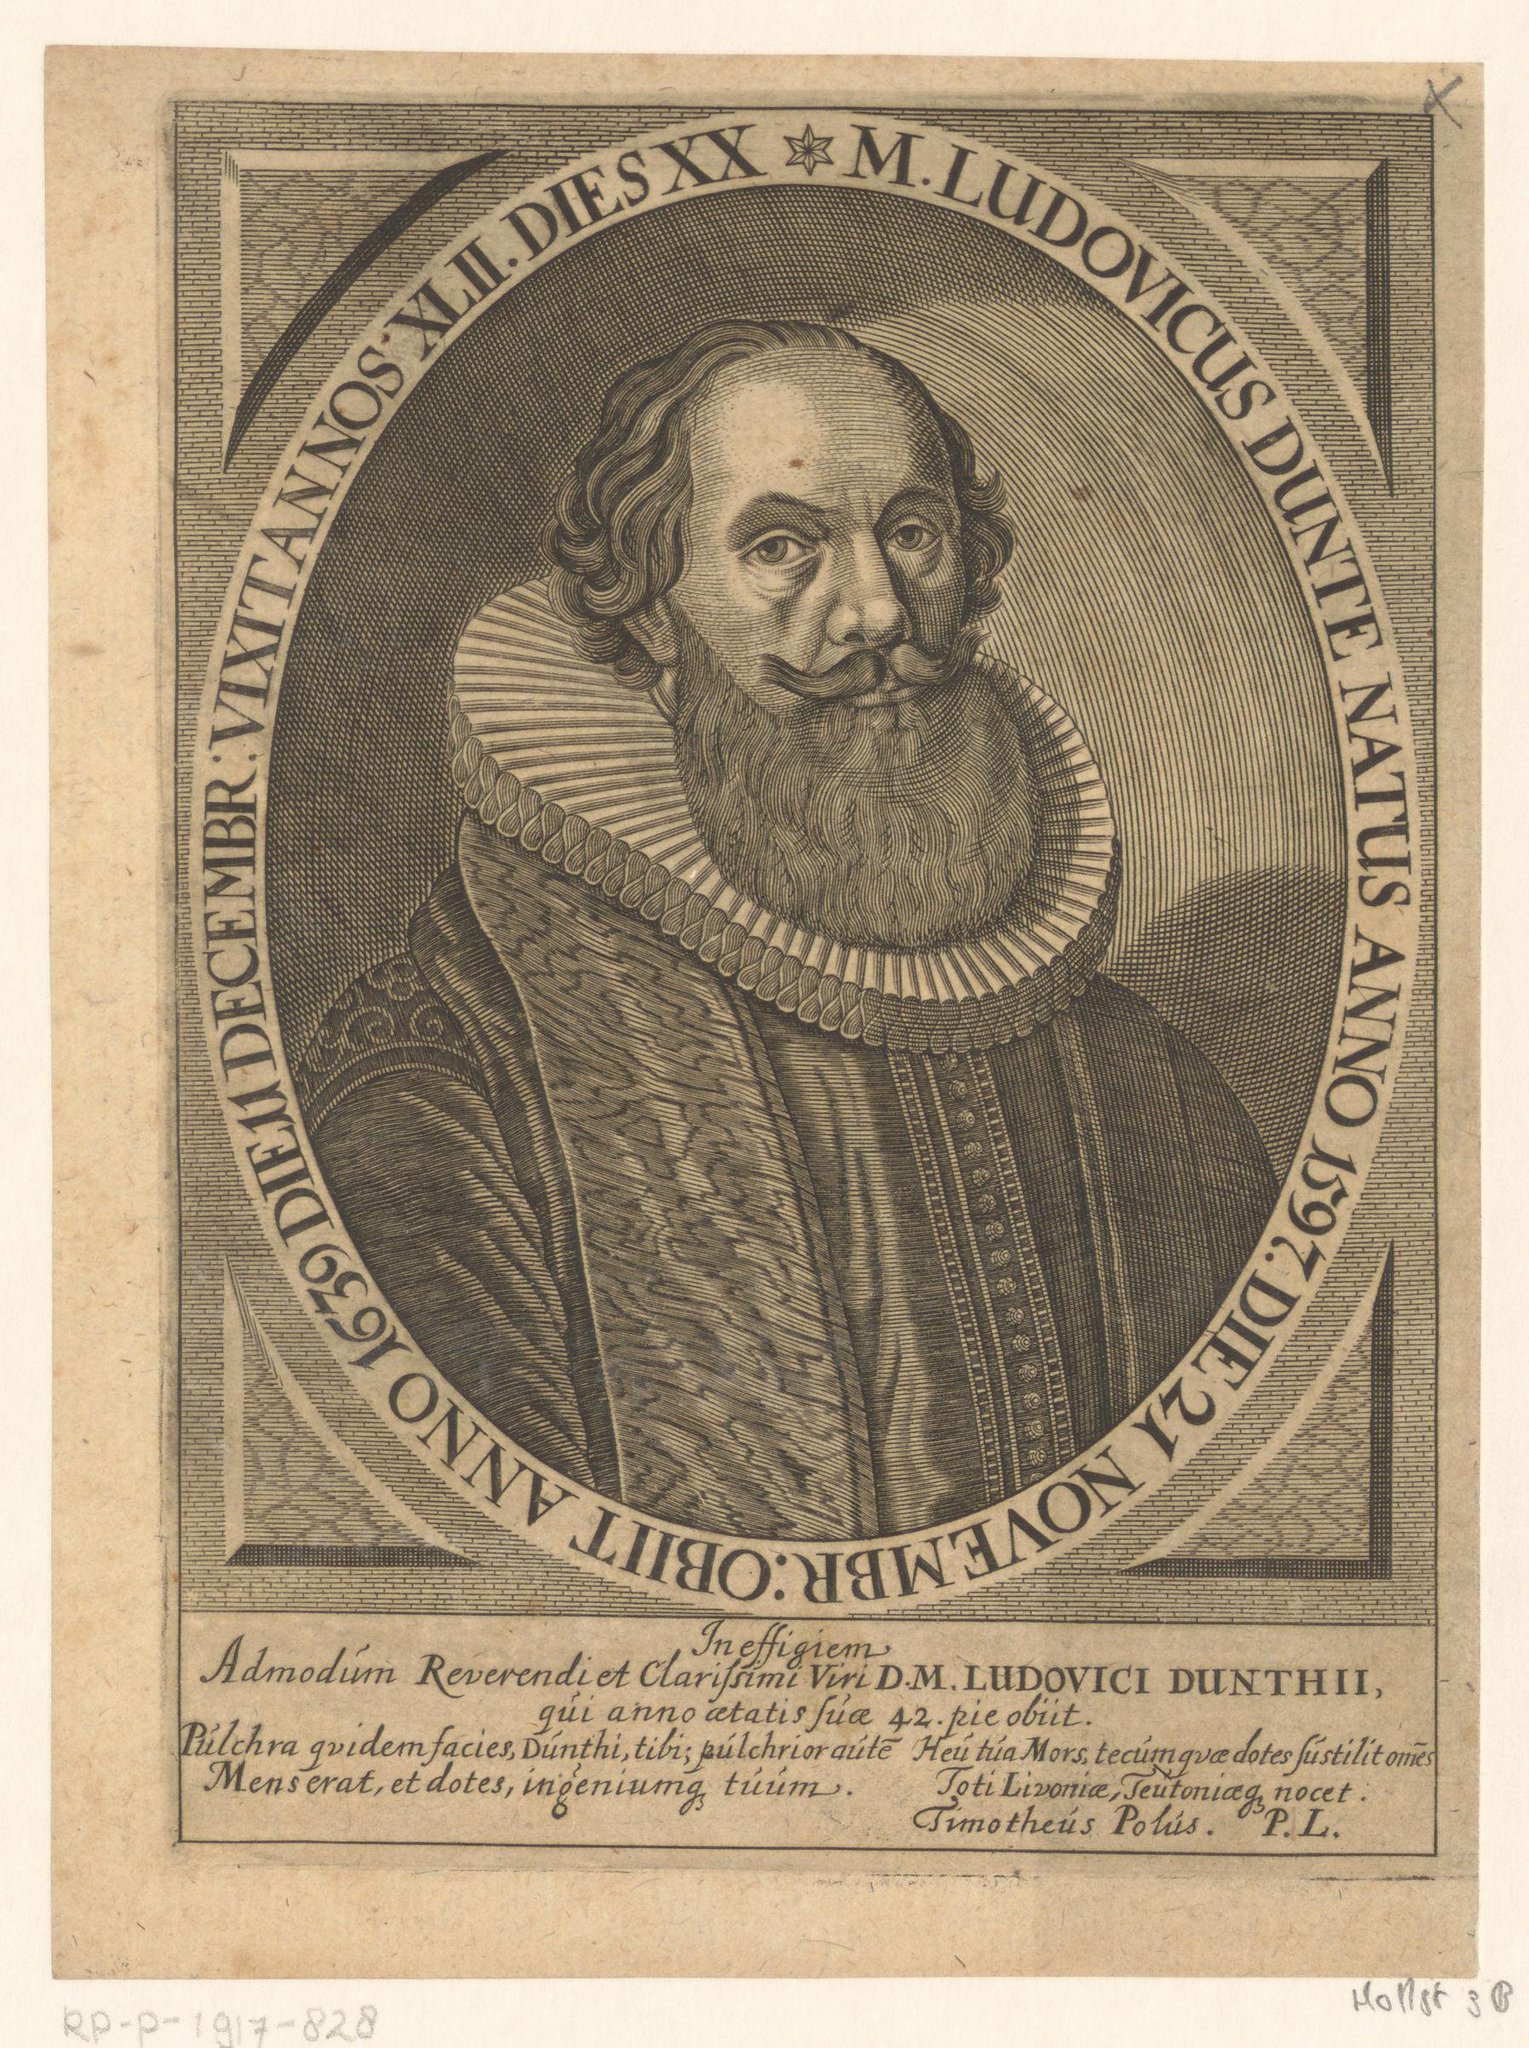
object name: print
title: Portret van Ludovicus Dunte op 42-jarige leeftijd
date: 1640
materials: paper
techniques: engraving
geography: hamburg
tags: theologian, historical persons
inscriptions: collector's mark: Lugt 2228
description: Tekst in het Latijn in de omlijsting en in de ondermarge.